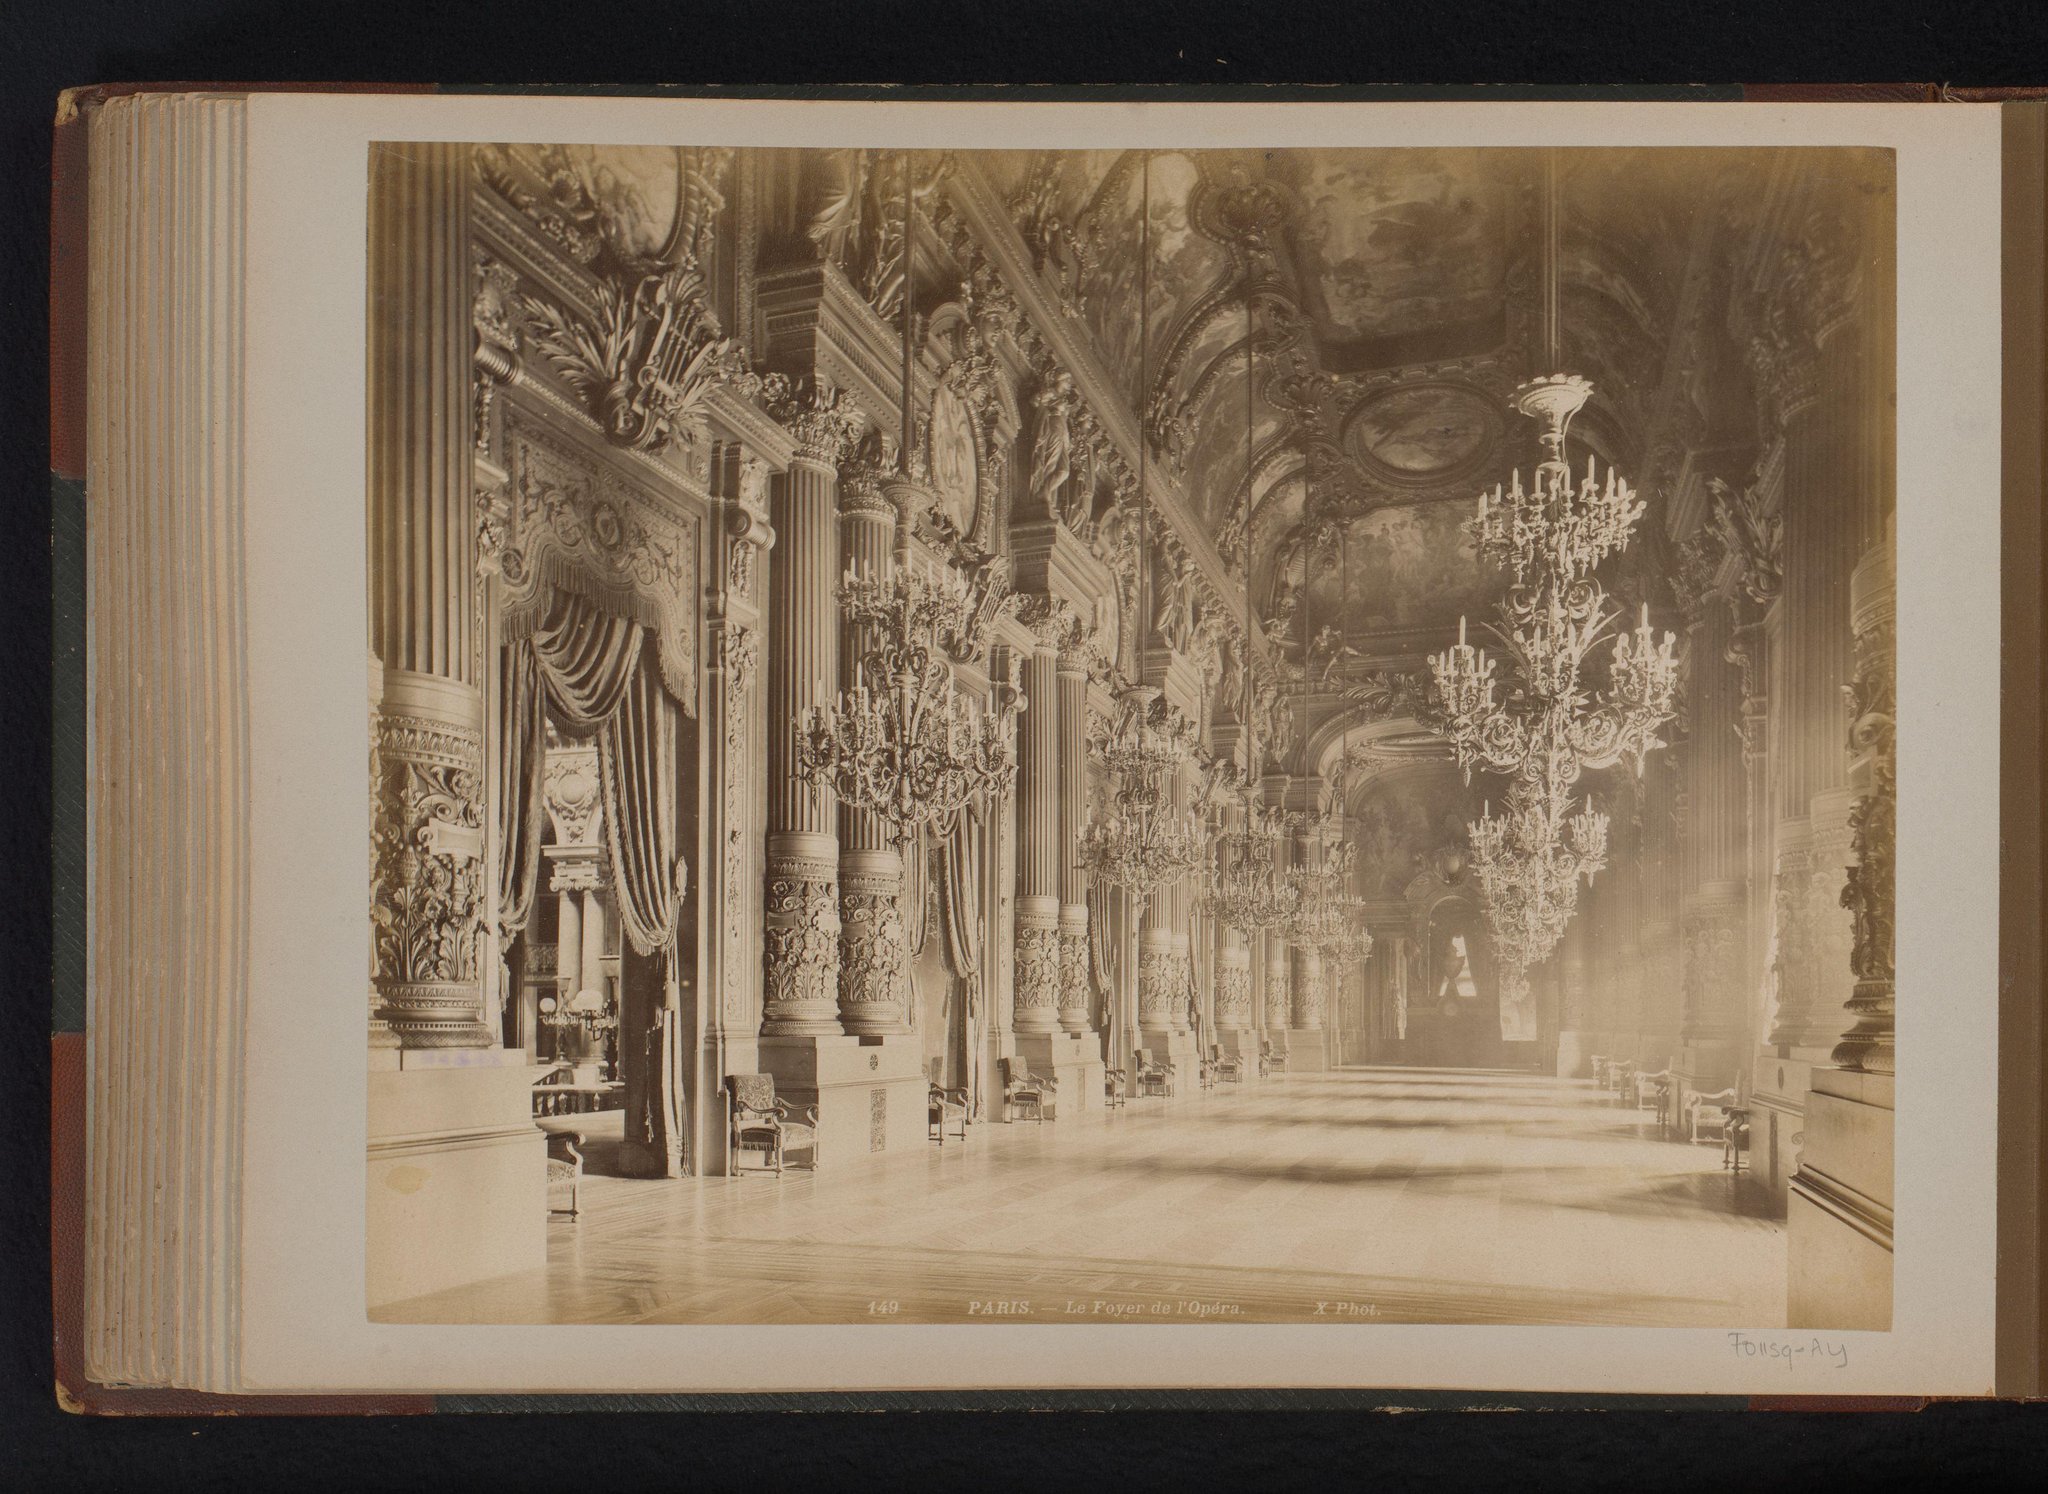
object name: photograph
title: PARIS. - Le Foyer de l'Opéra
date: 1870-1890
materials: photographic support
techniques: albumen print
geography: paris opera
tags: chandelier, candelabrum, opera house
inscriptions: number: ‘149’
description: Onderdeel van Reisalbum met opnames van bezienswaardigheden in Zweden, Noorwegen, Denemarken, Beieren, Milaan en Parijs.